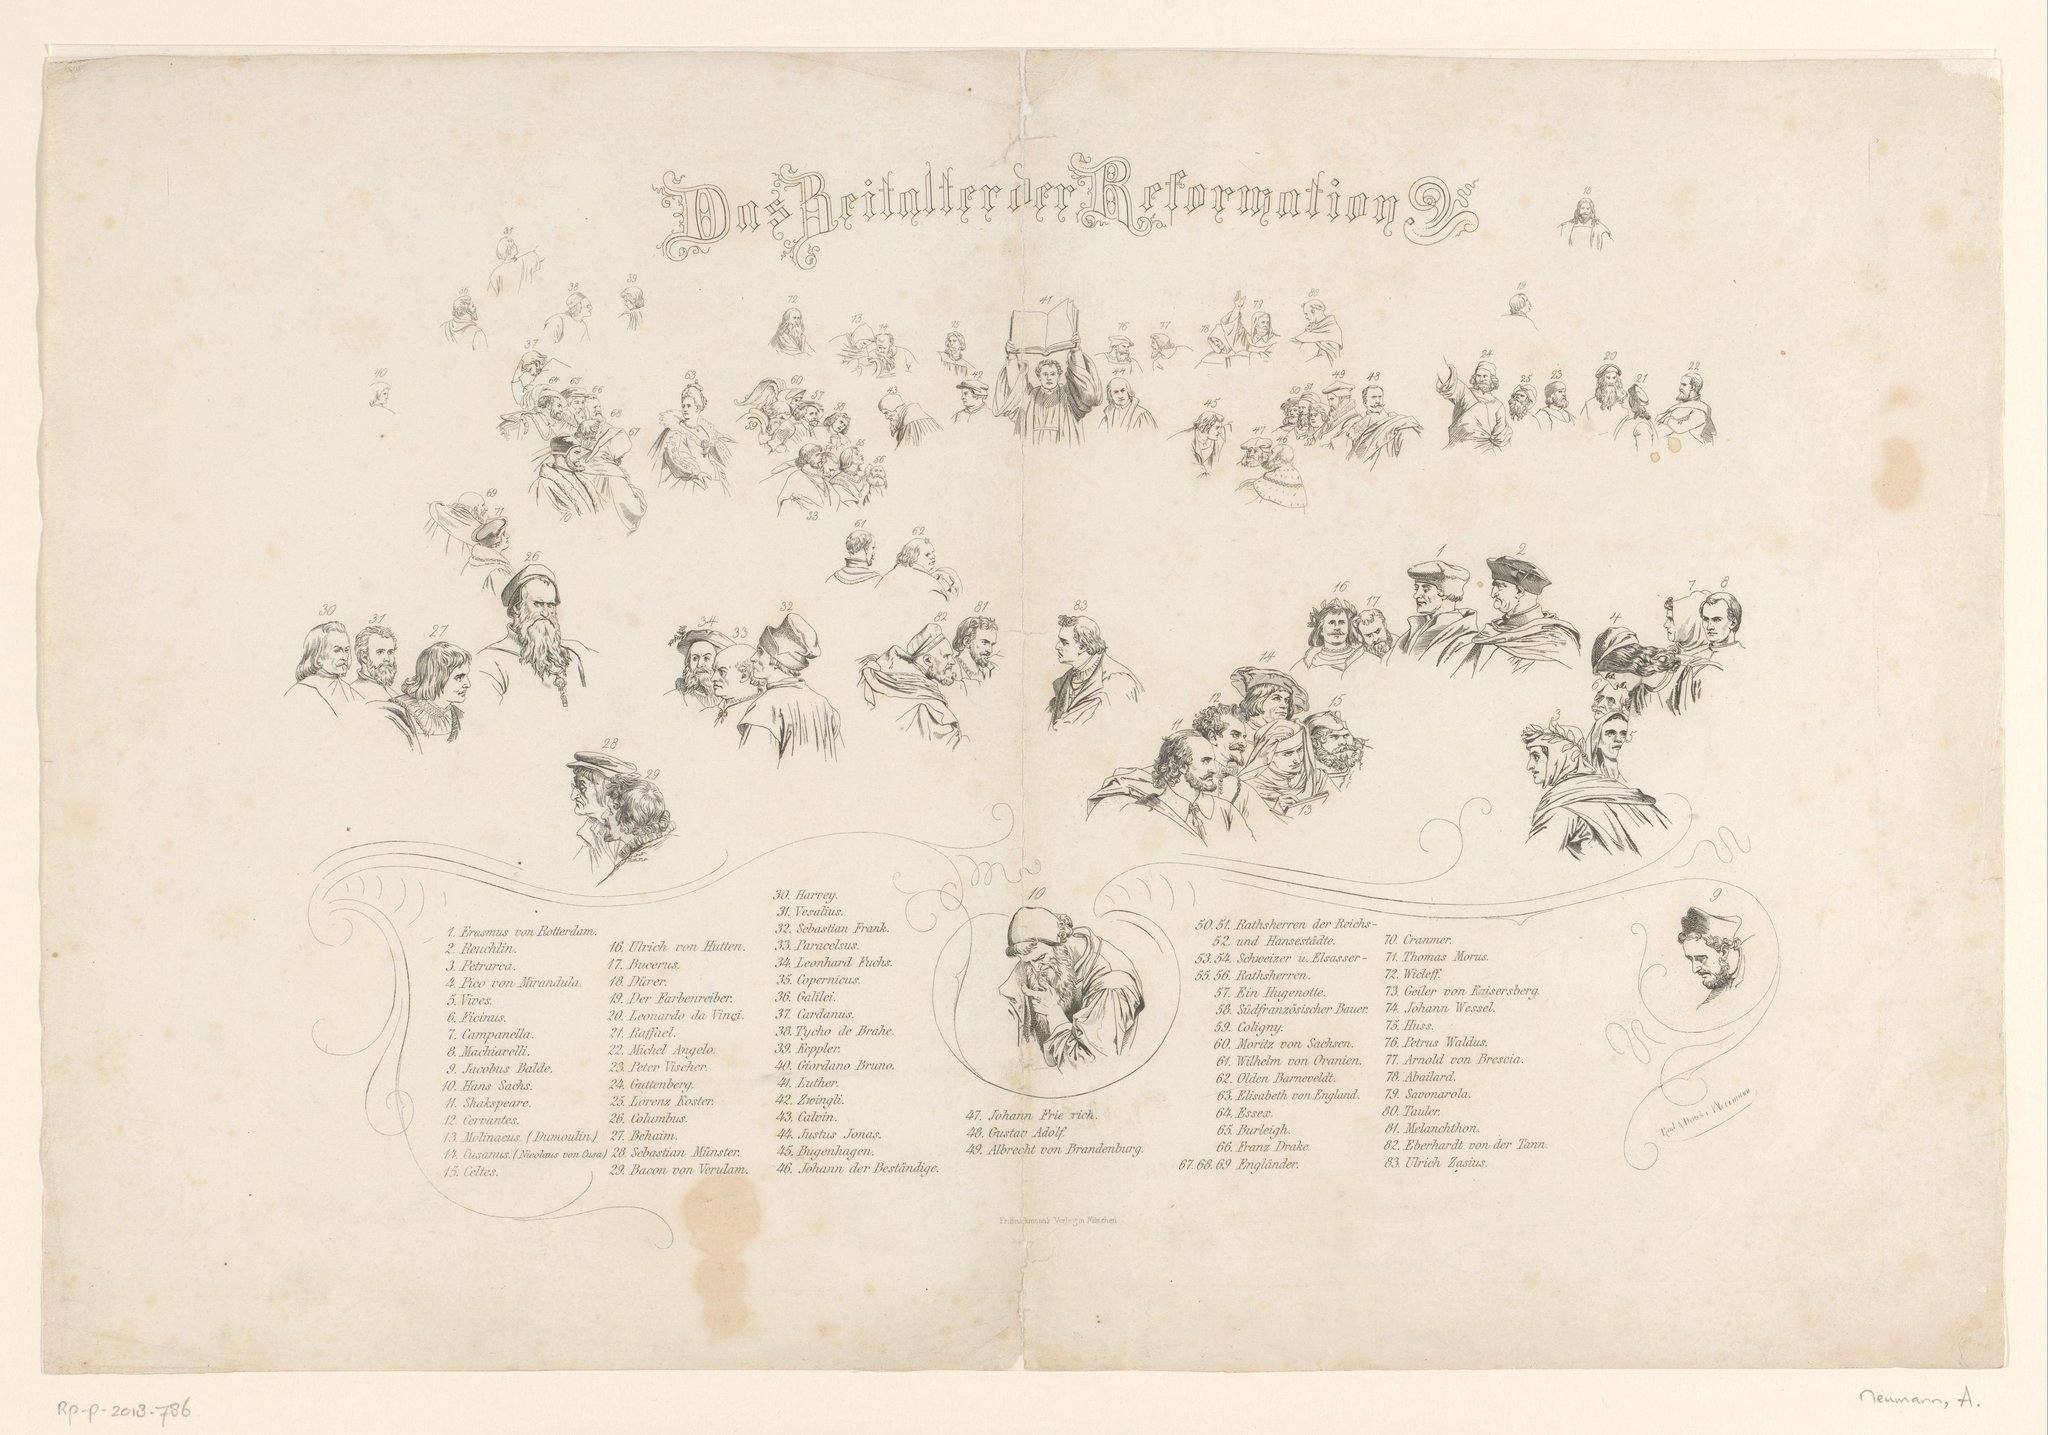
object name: print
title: Das Zeitalter der Reformation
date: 1863-1898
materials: paper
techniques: etching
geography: germany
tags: group of scholars or philosophers, historical persons, germany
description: Sleutel bij de prent "De kopstukken uit de Duitse Reformatie". Met legenda 1-83. Naar de - verloren gegane - wandschildering in het Neuen Museum zu Berlin.